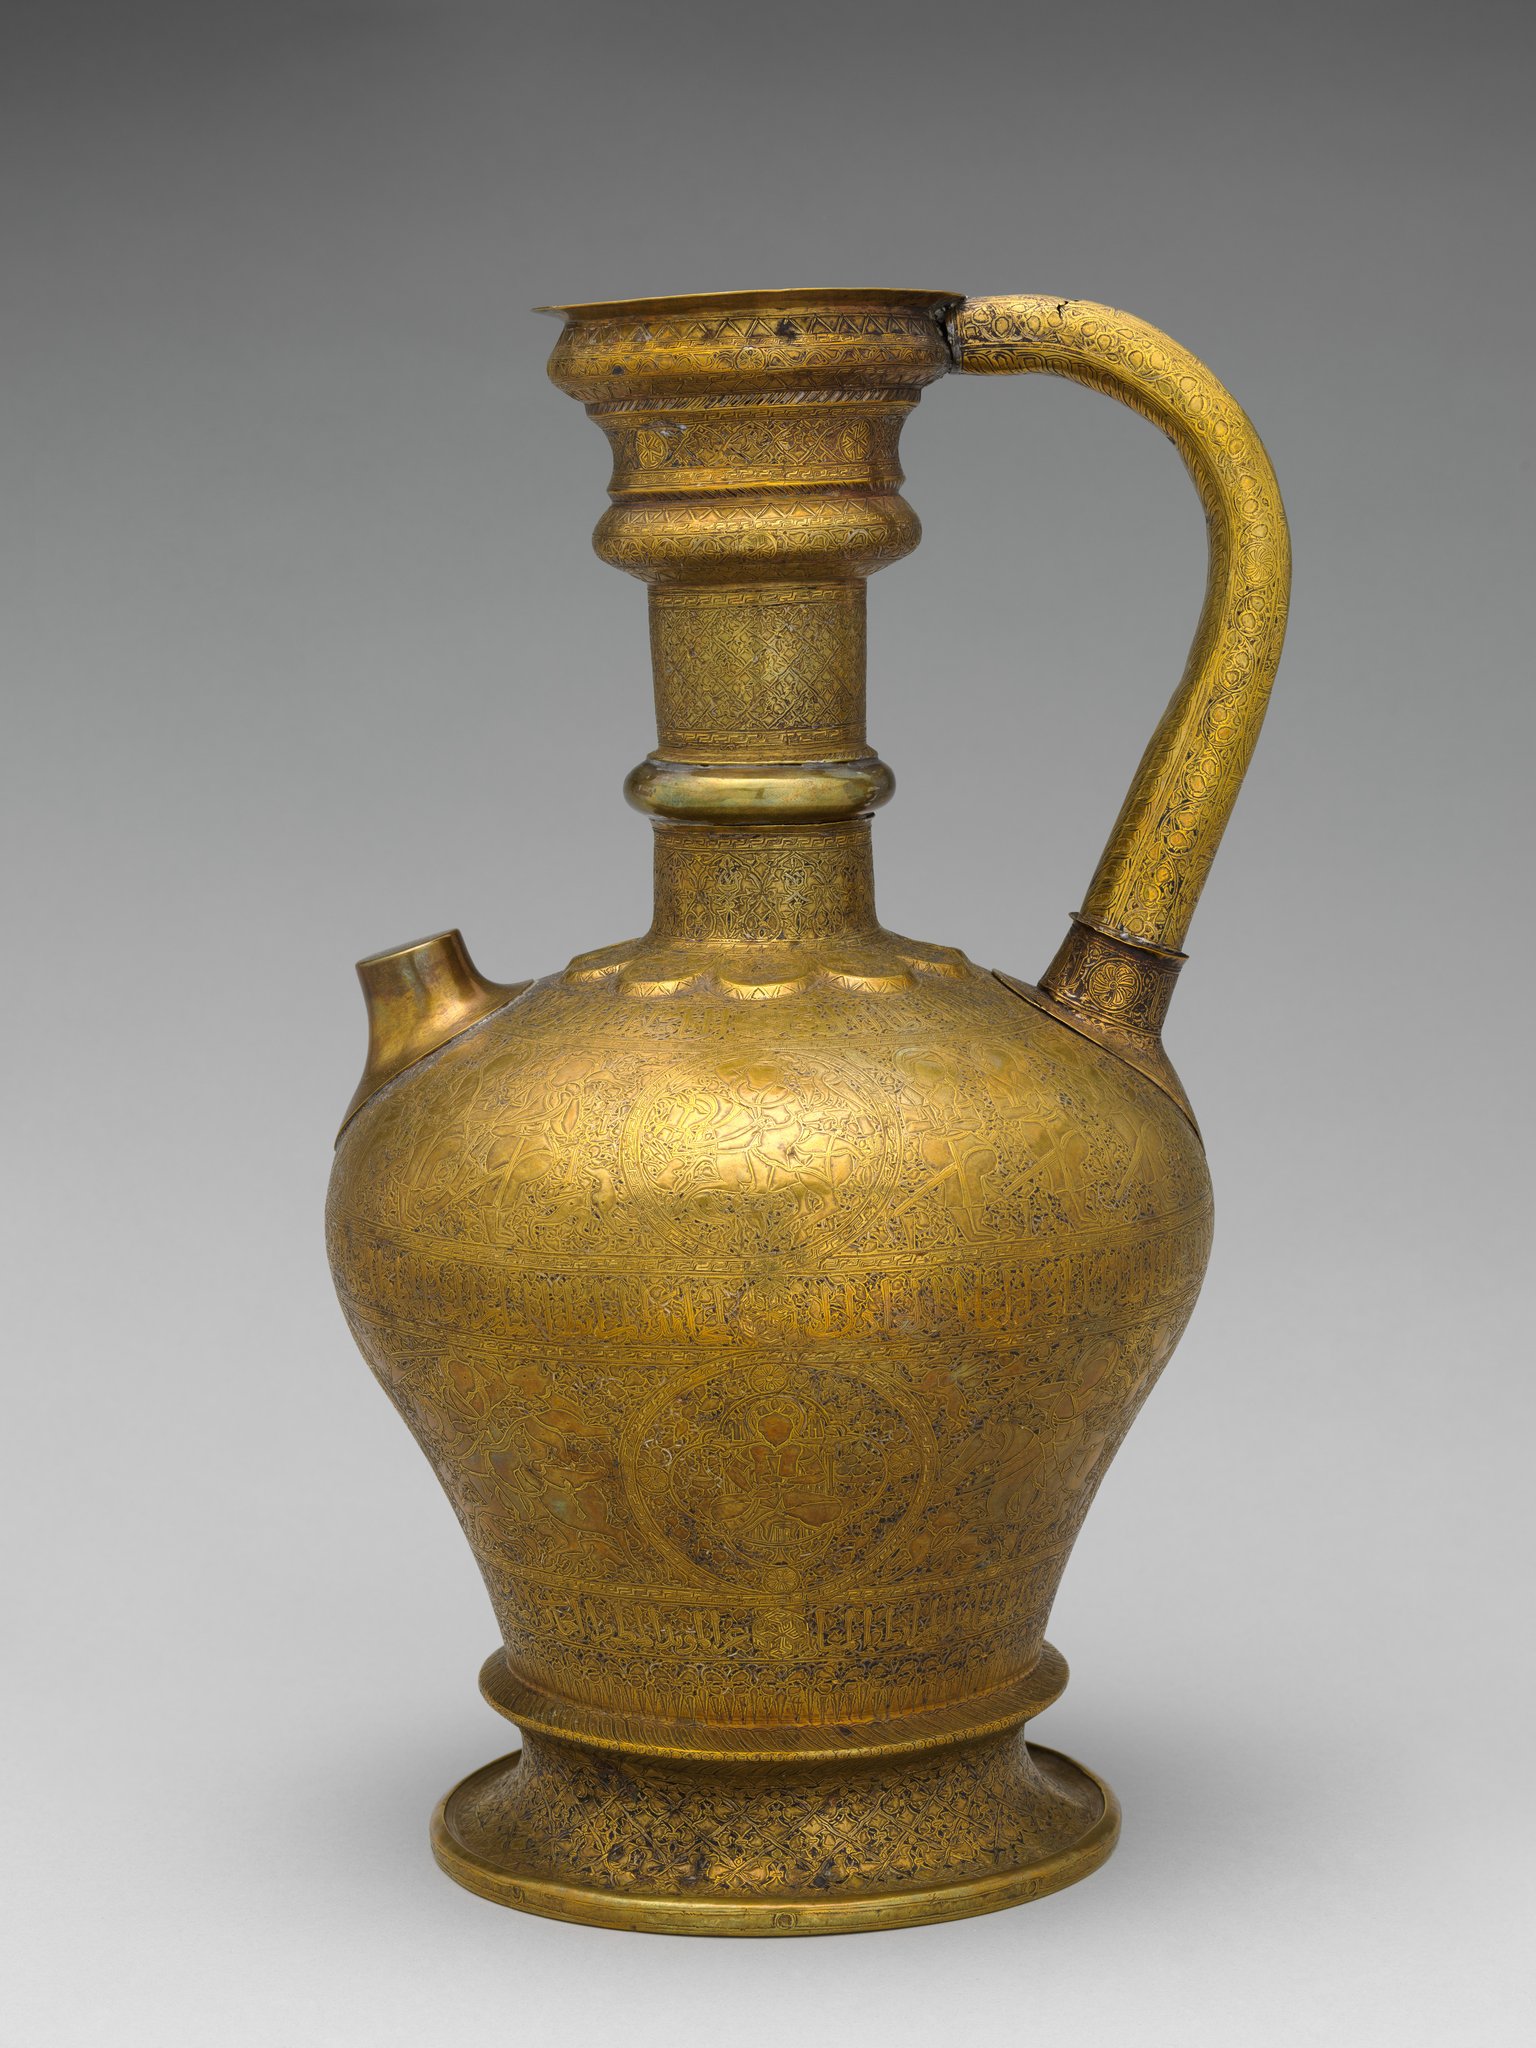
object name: ewer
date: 1301-1333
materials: brass, silver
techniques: inlay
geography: egypt or syria